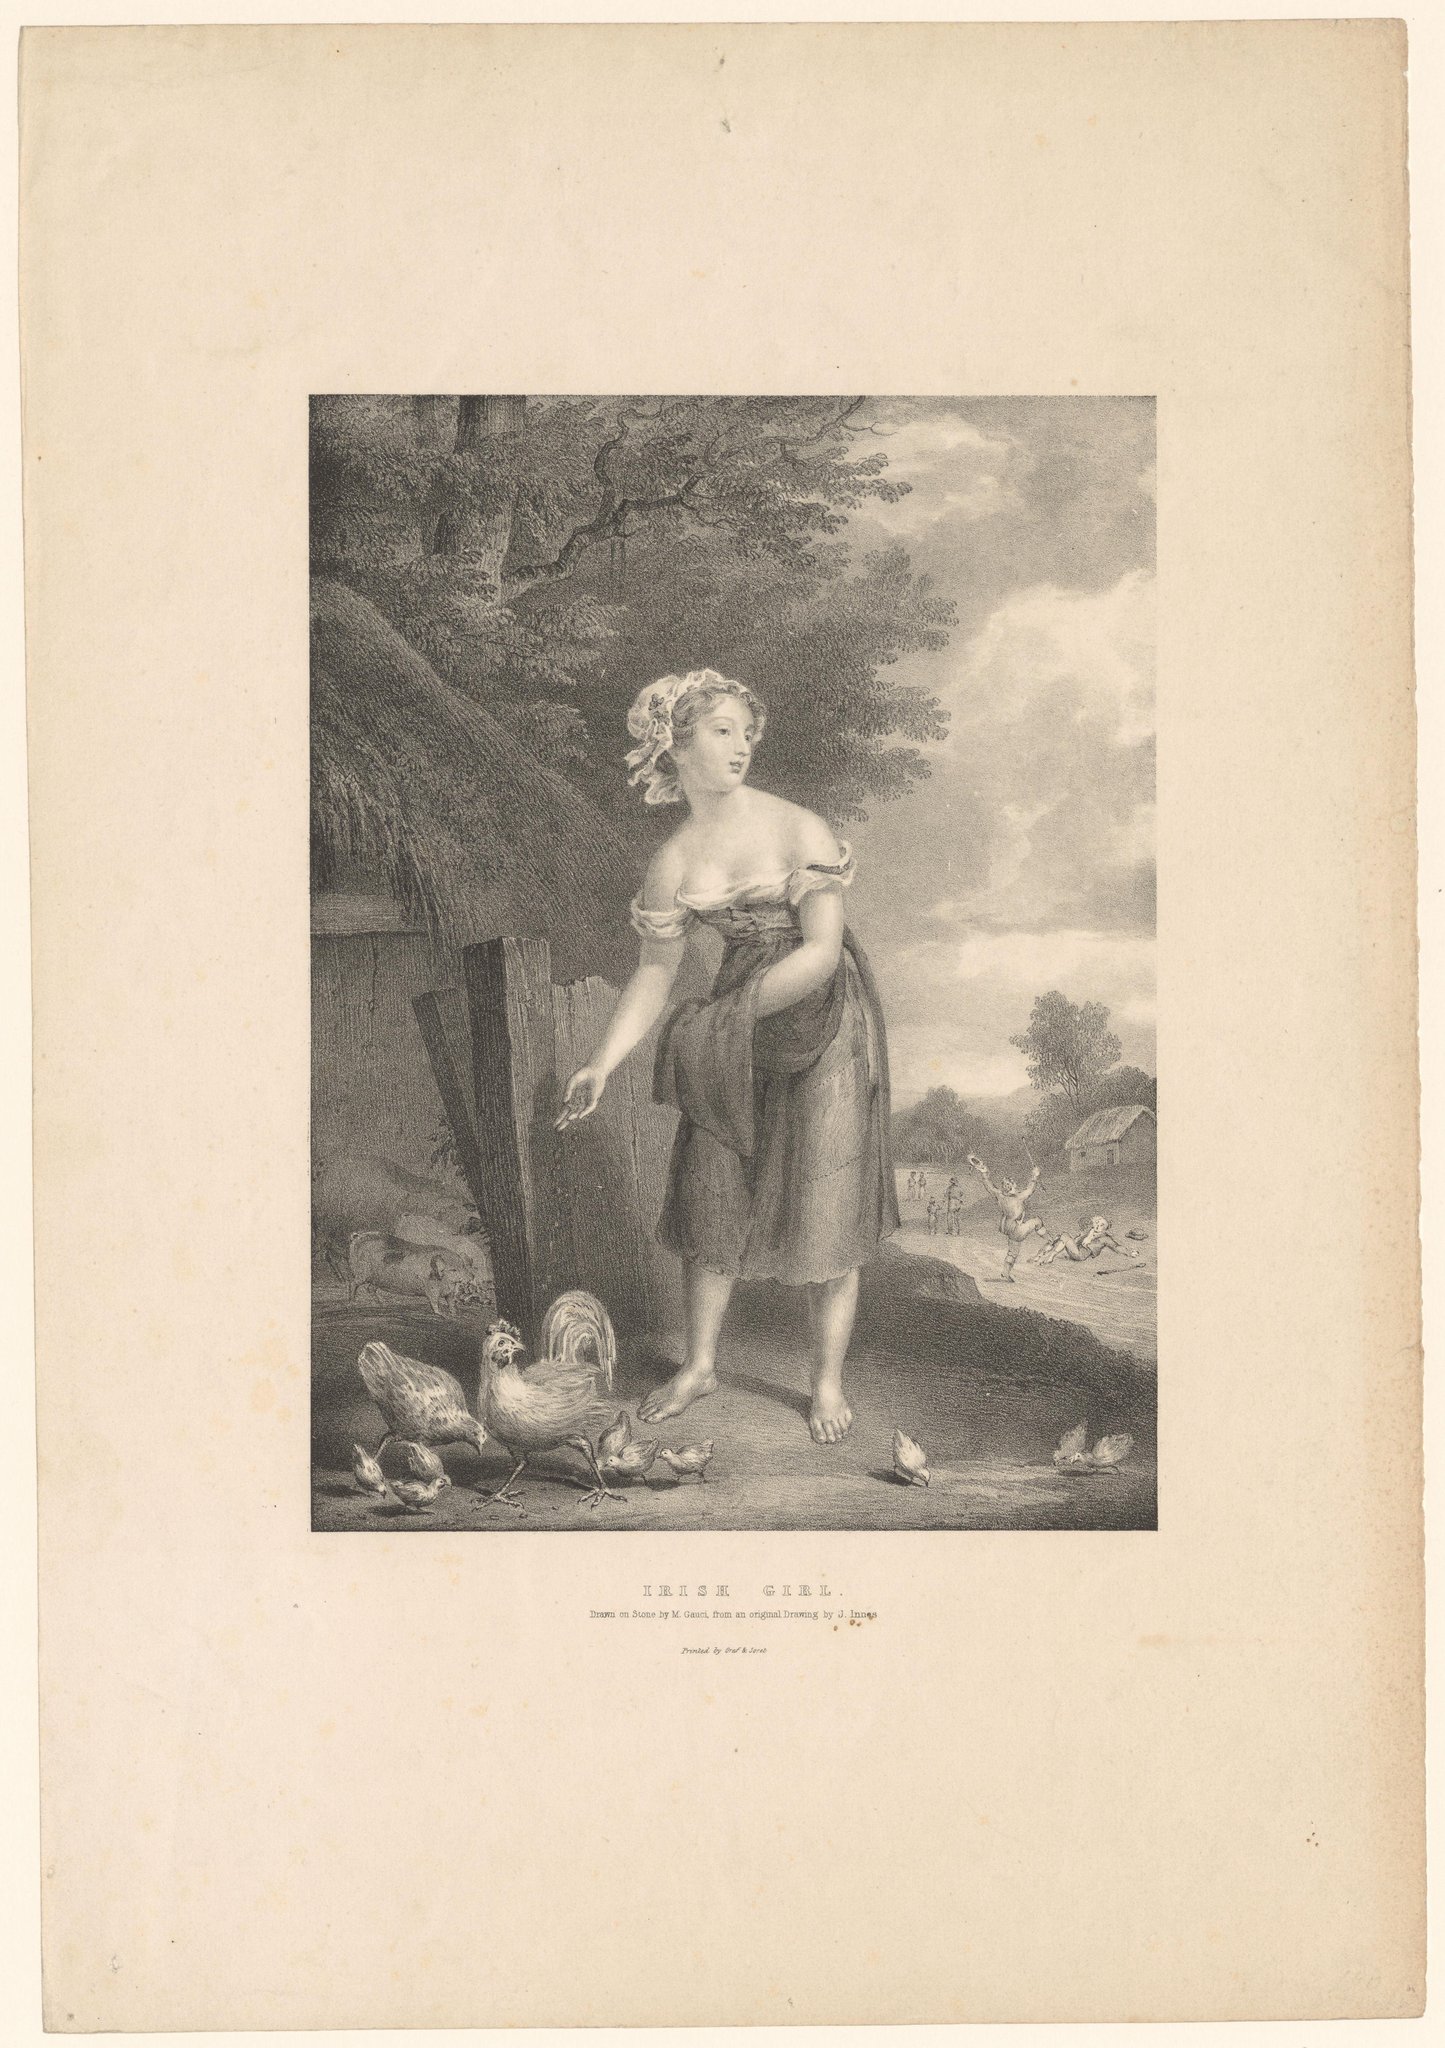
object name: print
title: Irish girl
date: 1820-1850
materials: paper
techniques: lithograph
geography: london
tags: giving food, girl (child between toddler and youth), fowl (cock, hen, chicken, etc.)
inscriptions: collector's mark: Lugt 2228